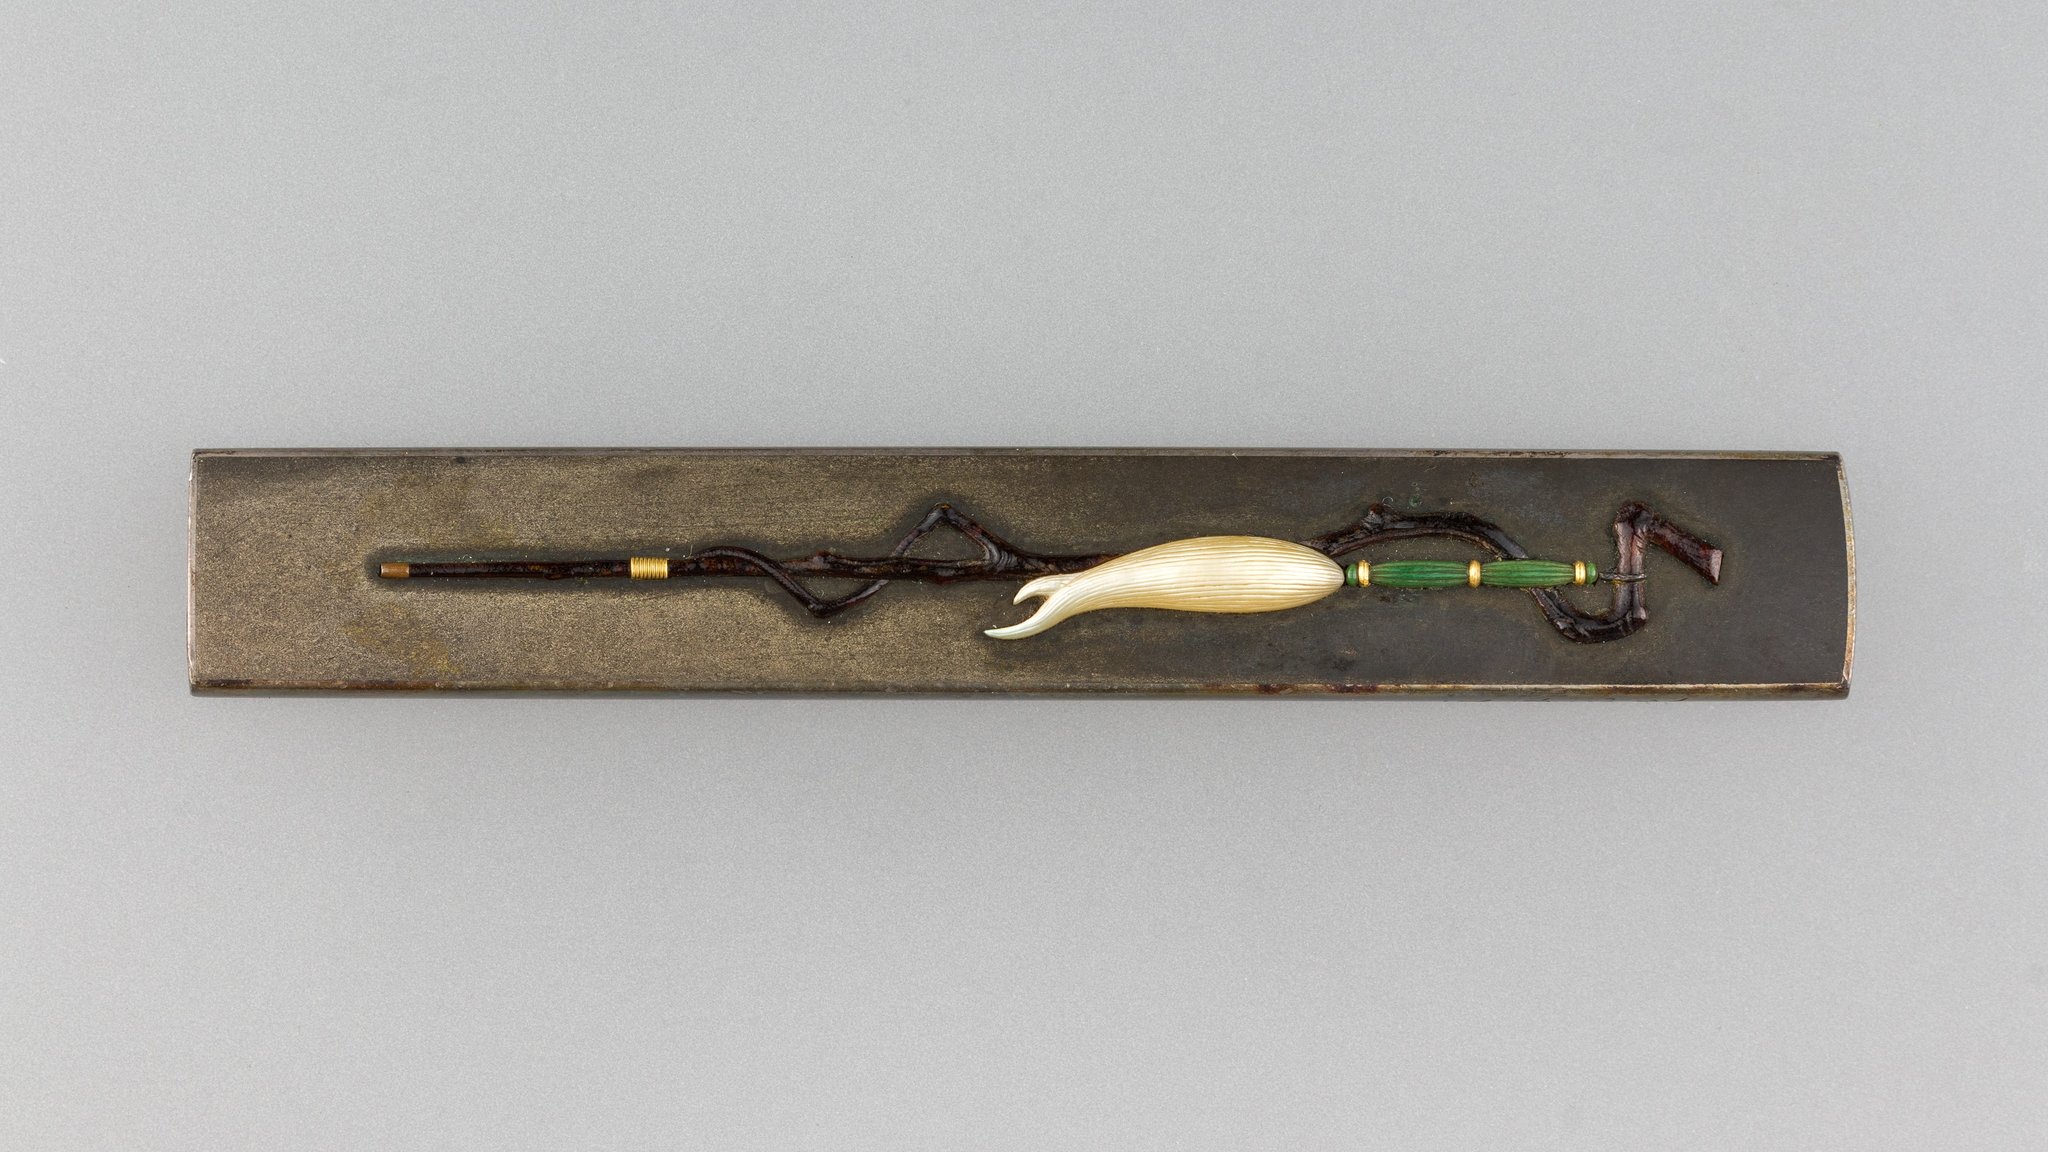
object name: knife handle kozuka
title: Knife Handle (Kozuka)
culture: japanese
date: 1701-1800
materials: copper, silver alloy, gold, jade, lacquer, mother of pearl, silver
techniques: urushi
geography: japan